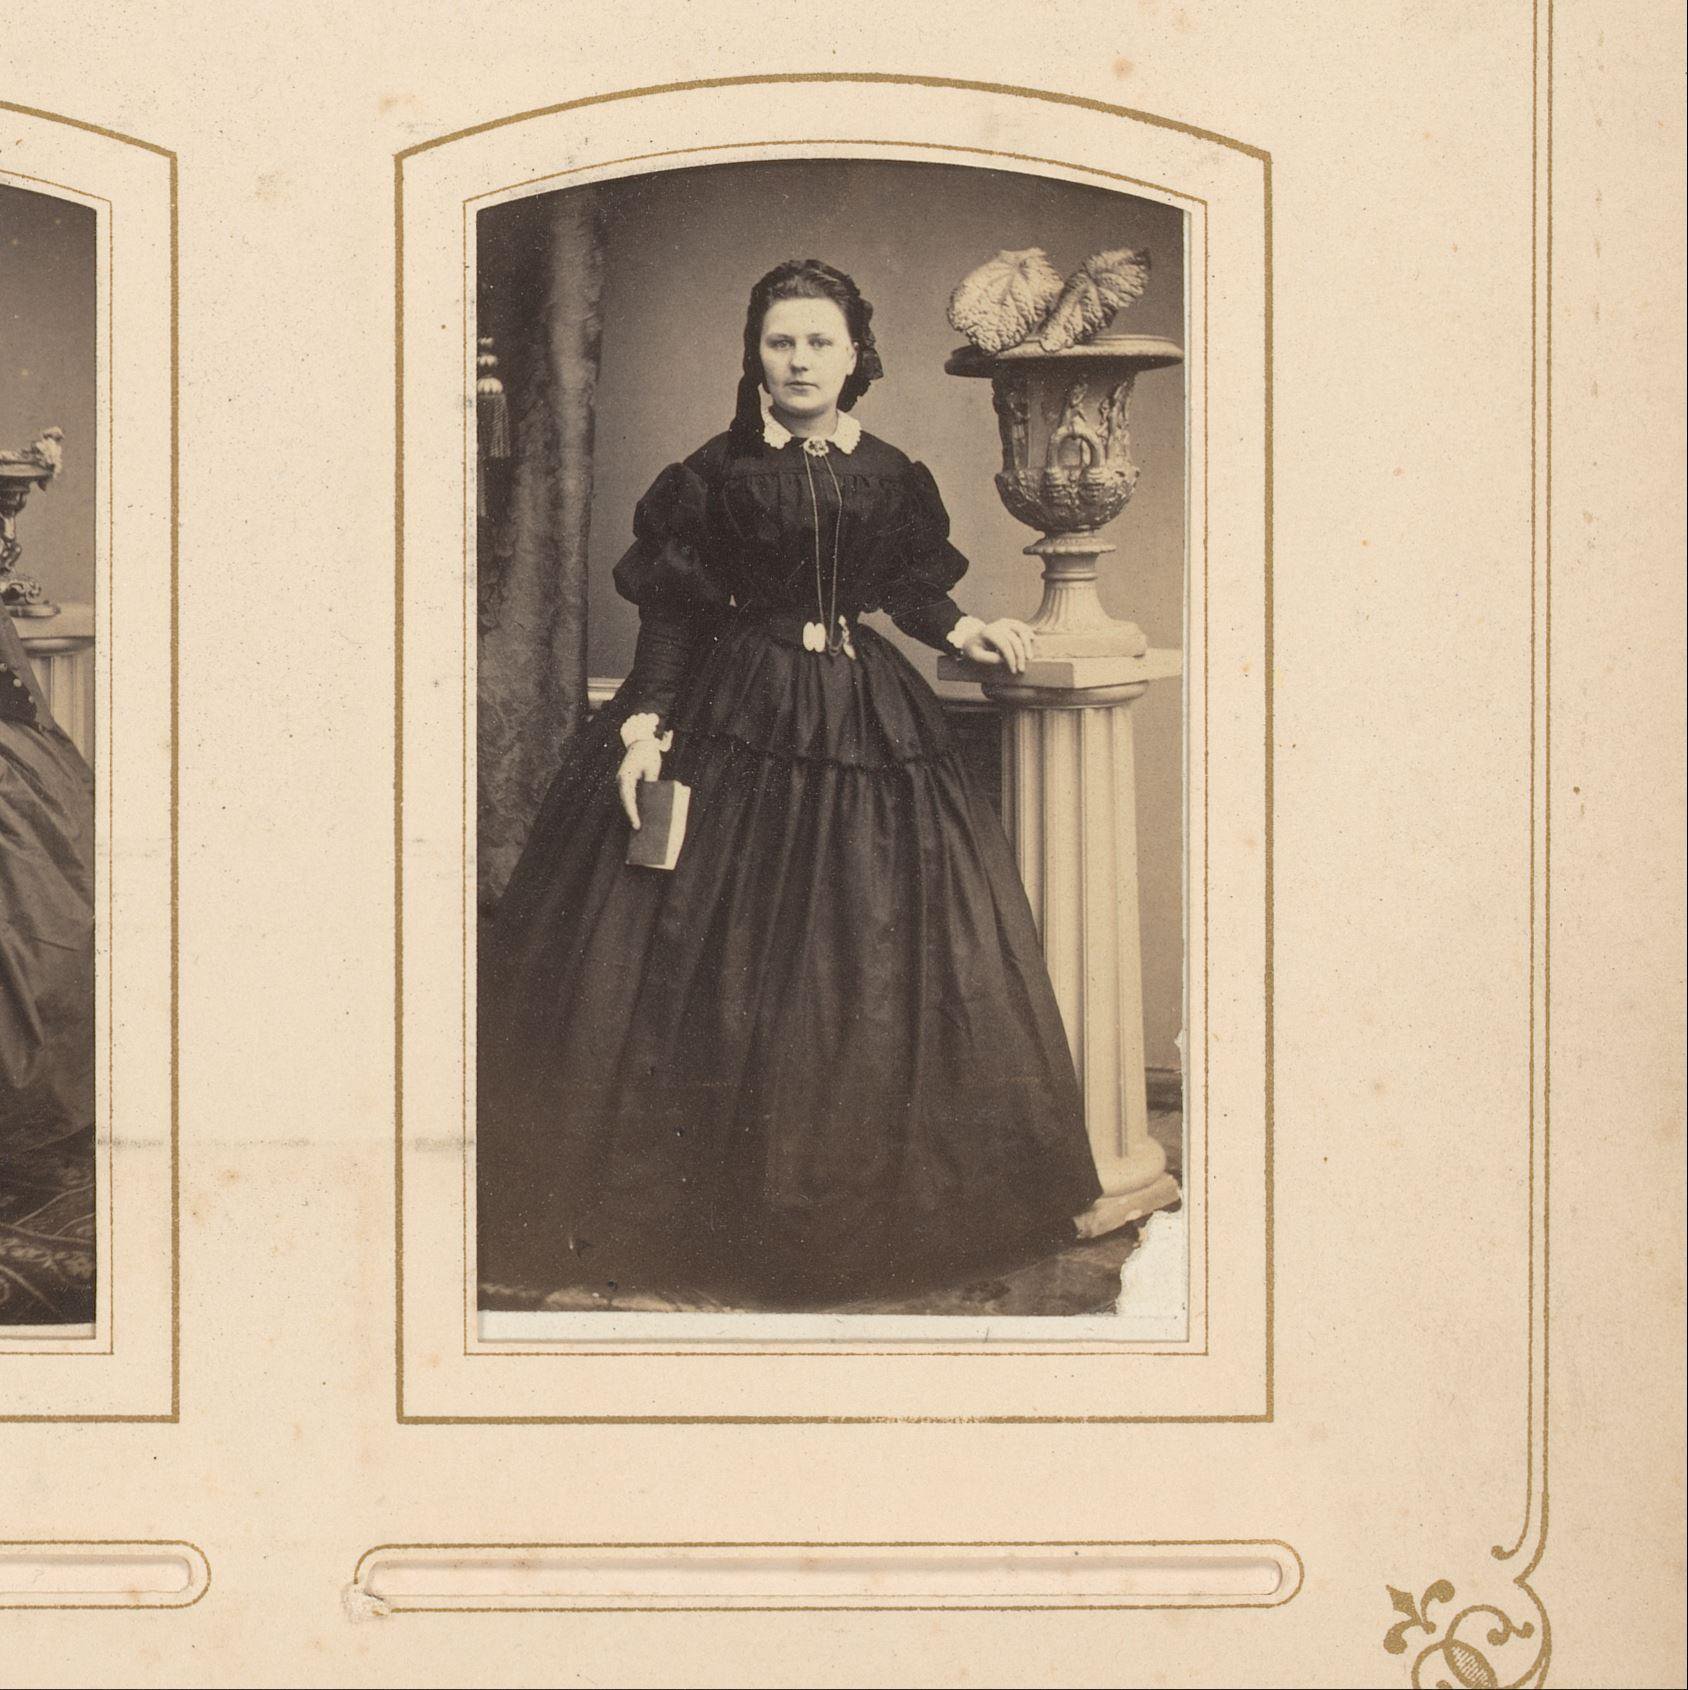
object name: carte de visite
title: Portret van een vrouw bij een sokkel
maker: th. schütz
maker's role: fotograaf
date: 1850-1900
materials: cardboard, photographic support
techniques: albumen print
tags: historical persons - bb - woman, pedestal of a piece of sculpture (perhaps in the form of a herm)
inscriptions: inscription: ‘TH. SCHÜTZ./ PHOTOGRAPH.’